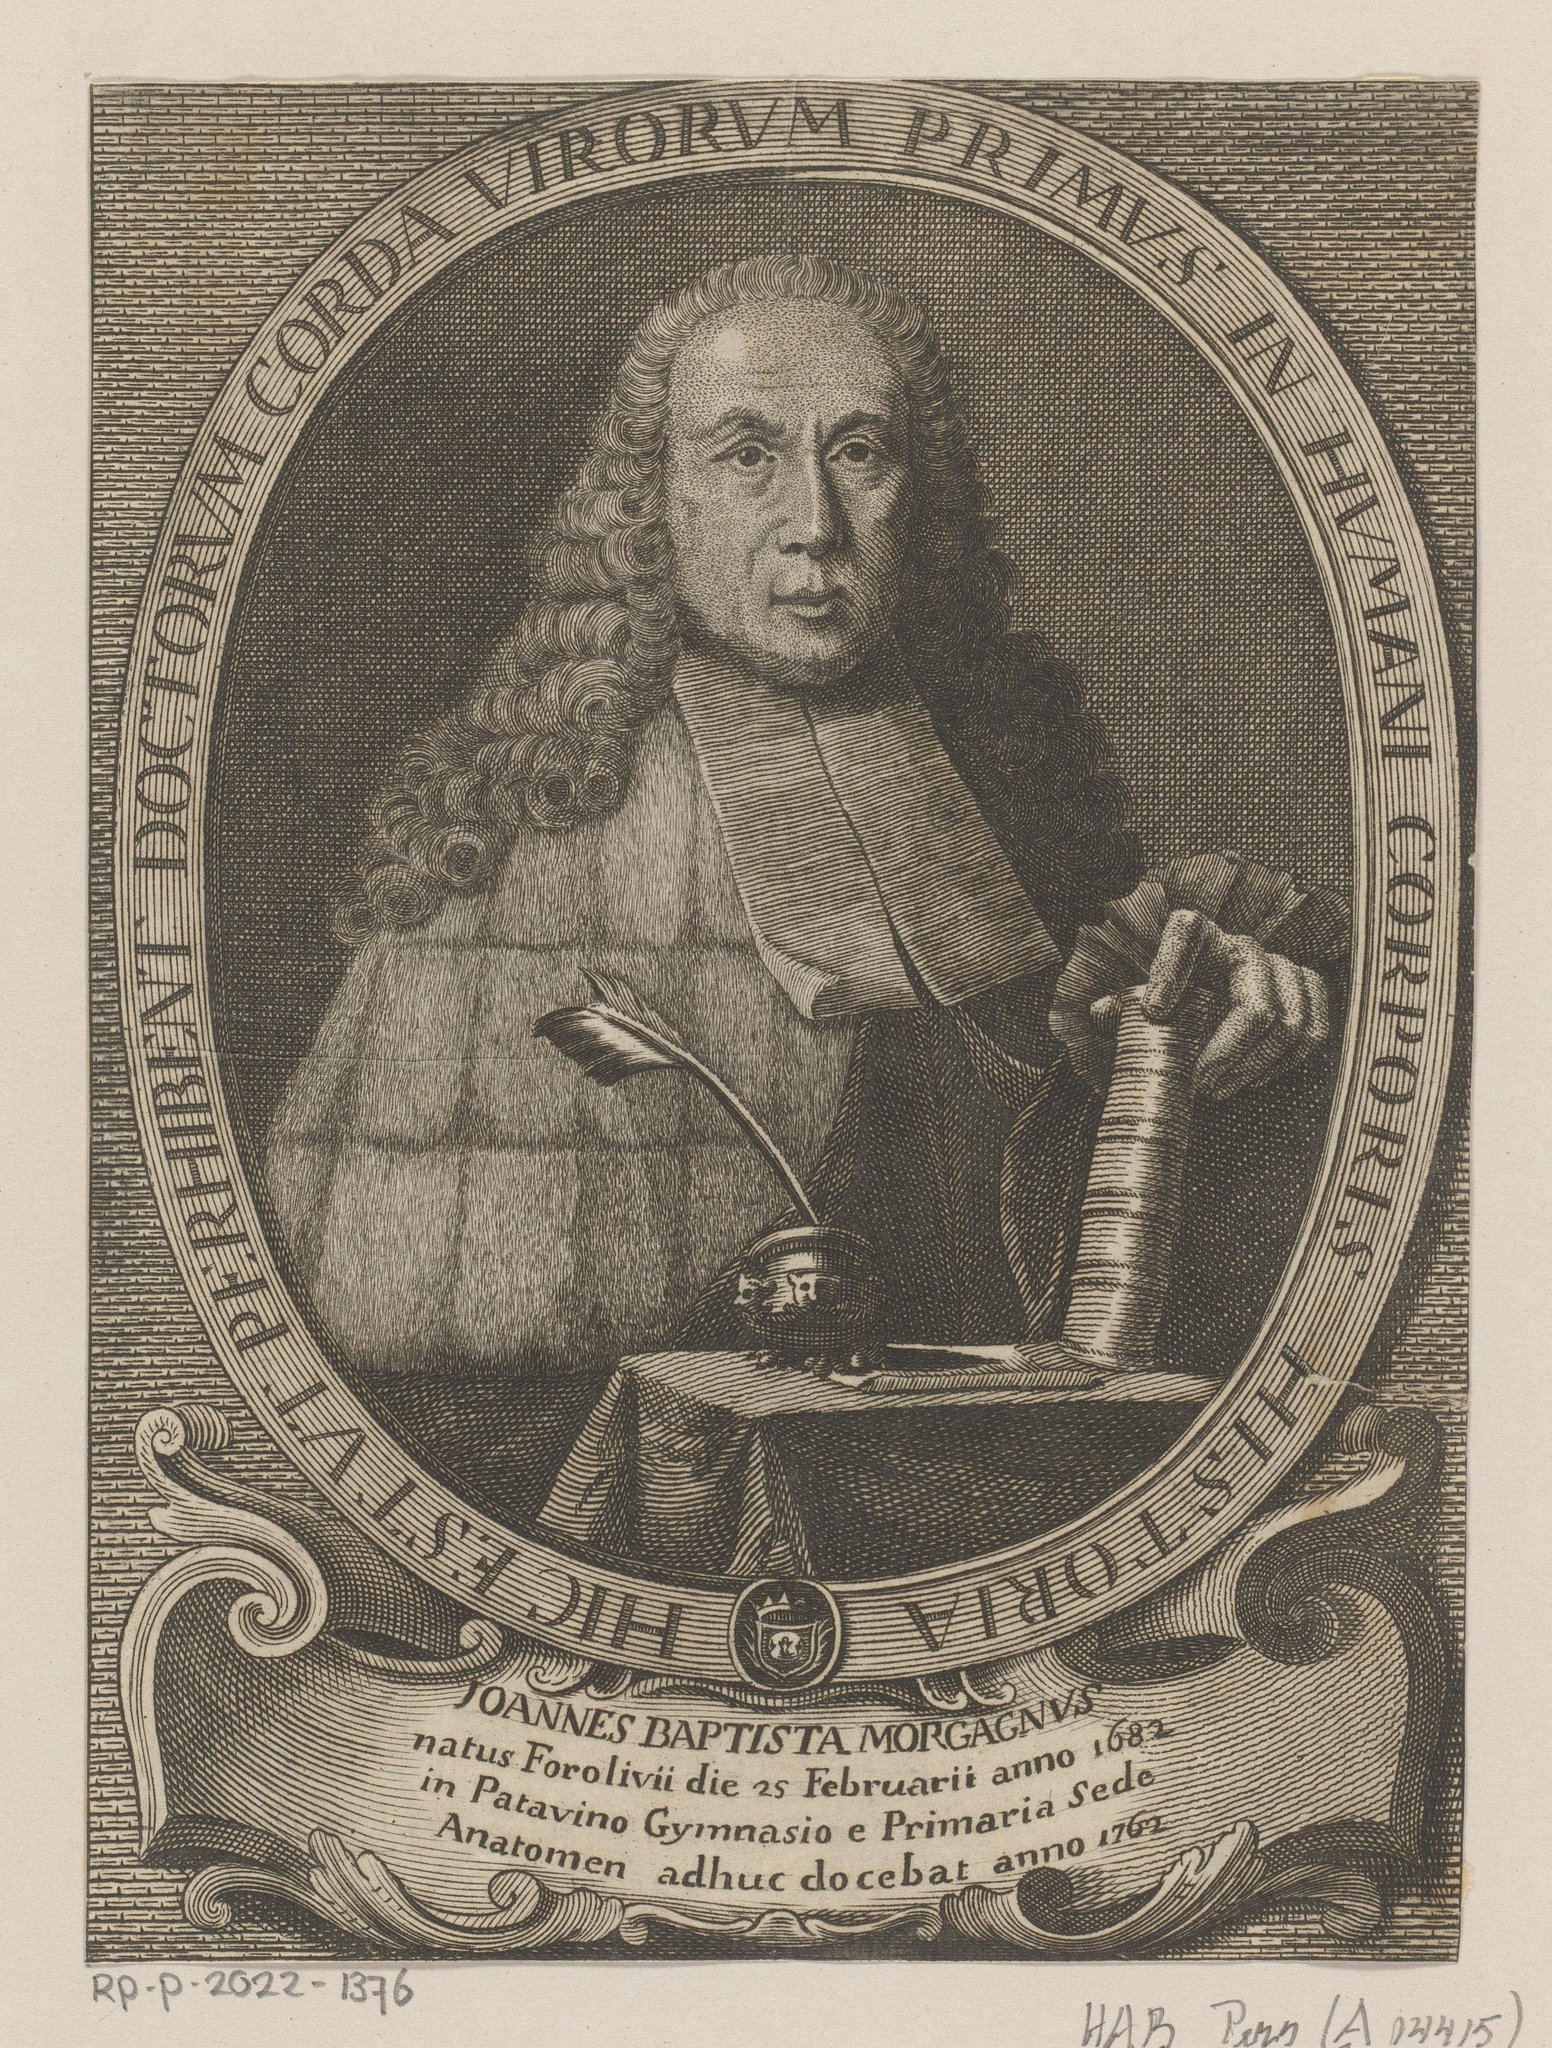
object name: titelblad, titelpagina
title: Joannes Baptista Morgagnus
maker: Anonymous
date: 1721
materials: paper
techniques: engraving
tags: historical persons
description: Prent waarschijnlijk uit: Deutsche Acta Eruditorum. Leipzig: Johann Friedrich Gleditsch zoon, 1721, dl. 73.